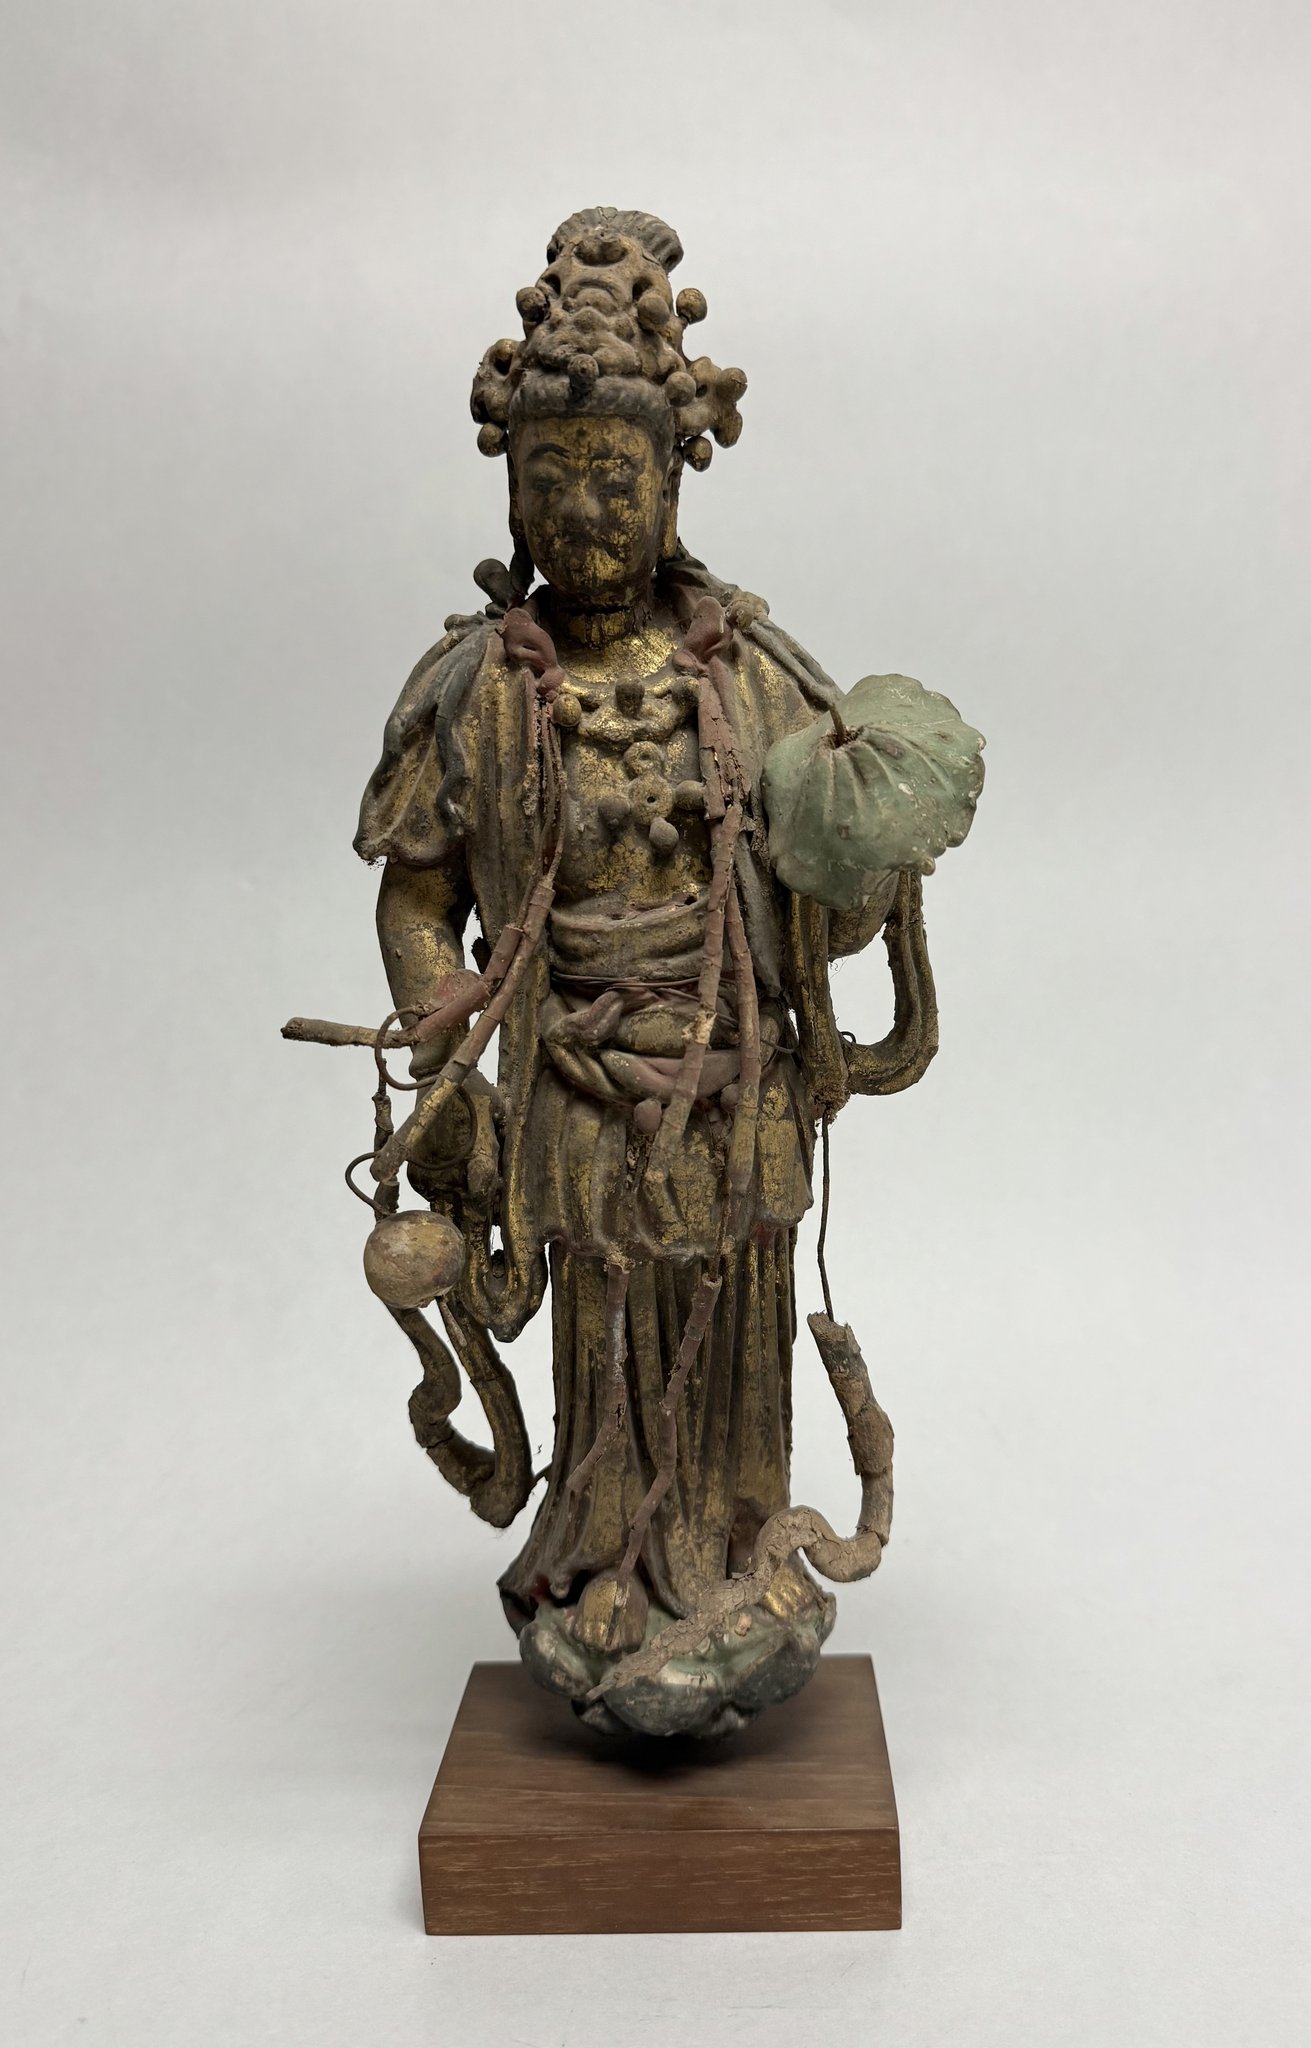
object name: statuette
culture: chinese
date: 1368-1644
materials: mud